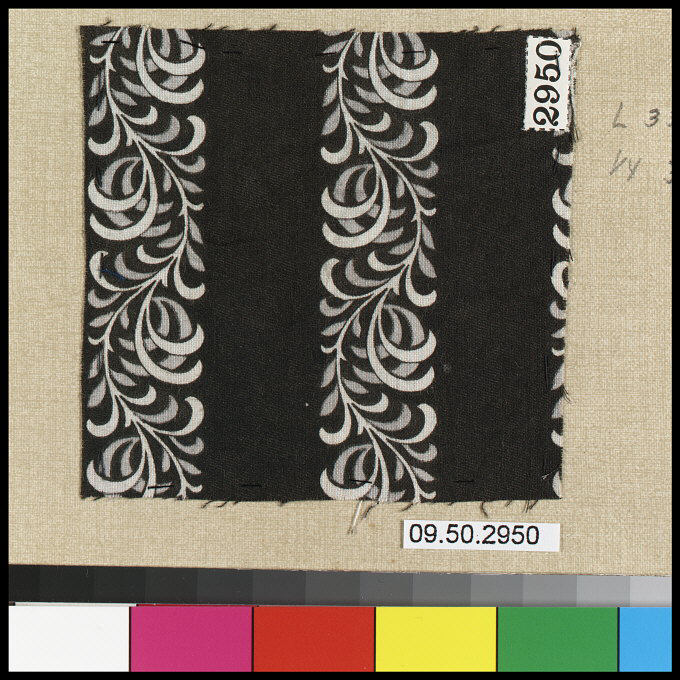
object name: piece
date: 1801-1900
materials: cotton